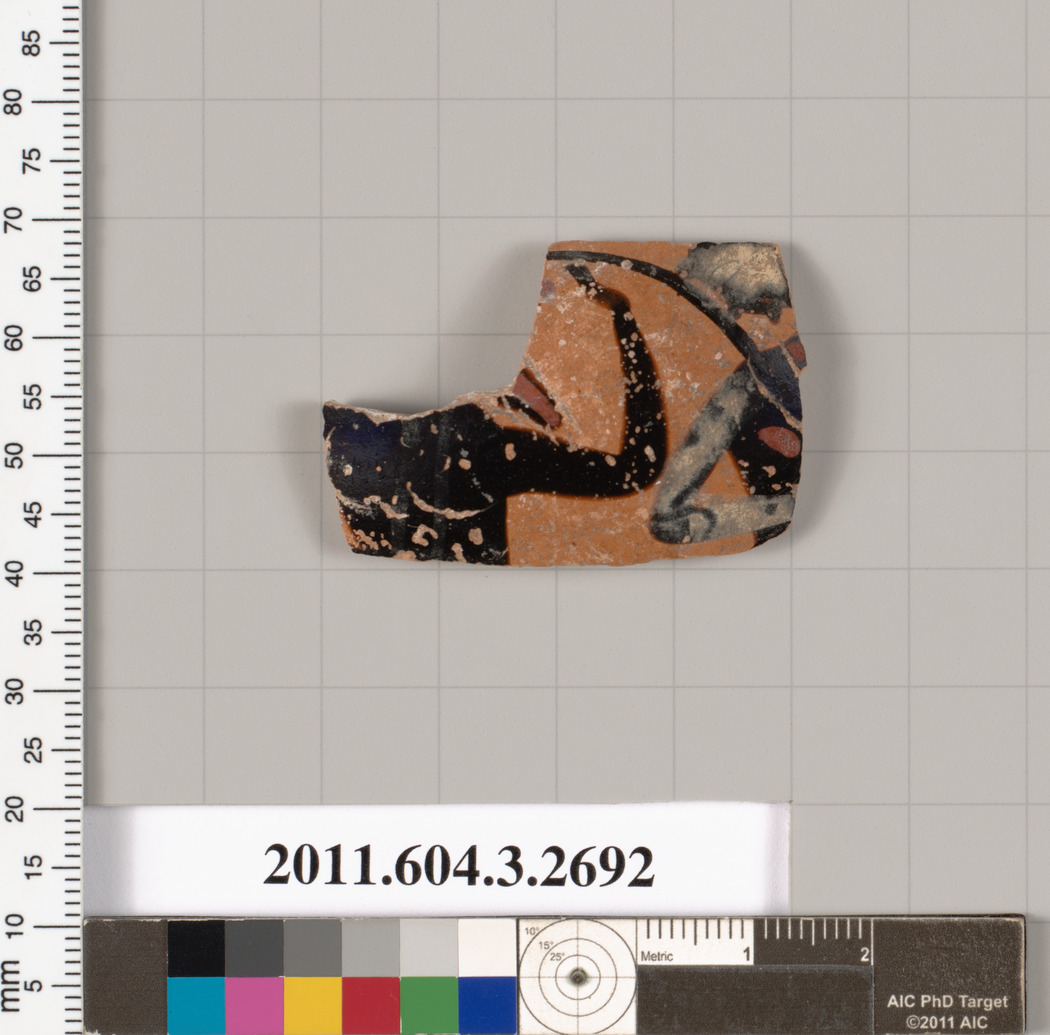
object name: oinochoe fragment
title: Terracotta fragment of an oinochoe (jug)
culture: greek, attic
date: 534-468 BCE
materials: terracotta